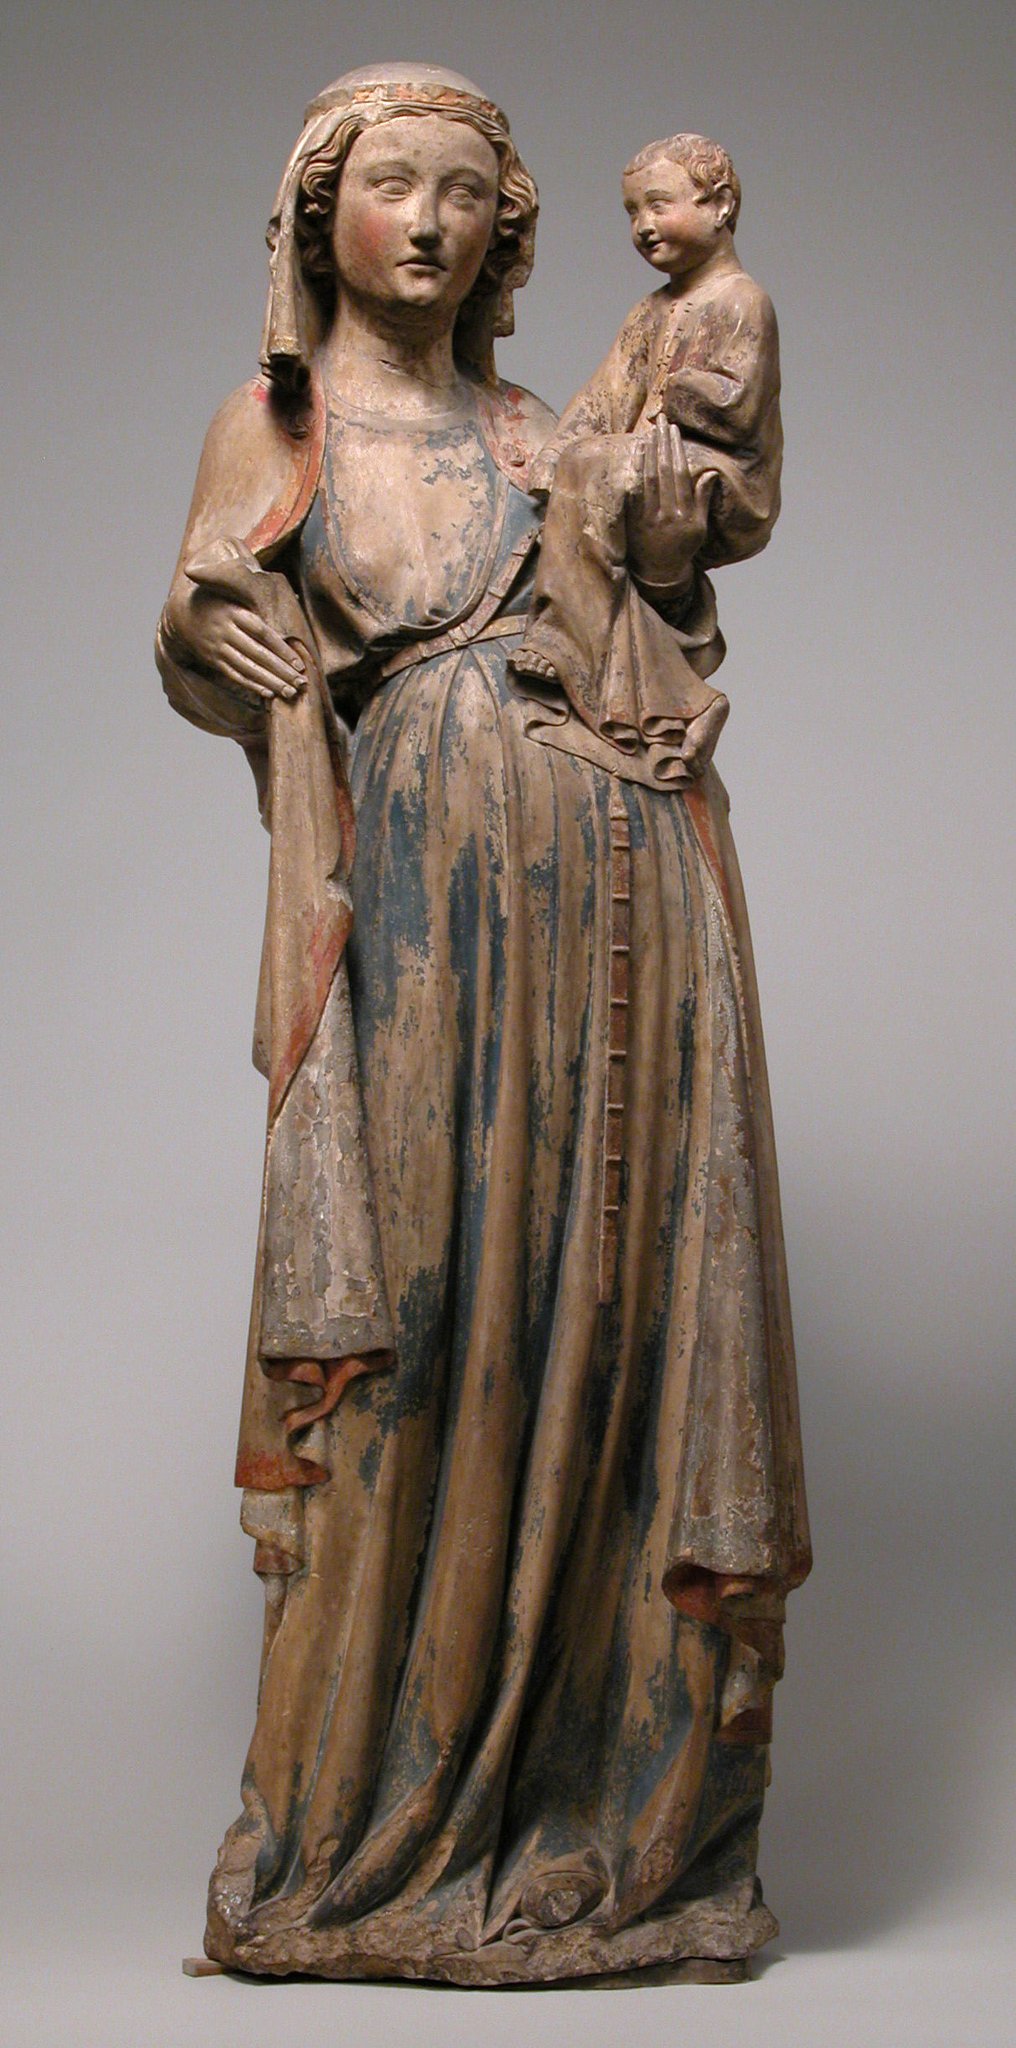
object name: statue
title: Virgin and Child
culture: french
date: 1301-1325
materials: limestone, paint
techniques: gilding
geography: france